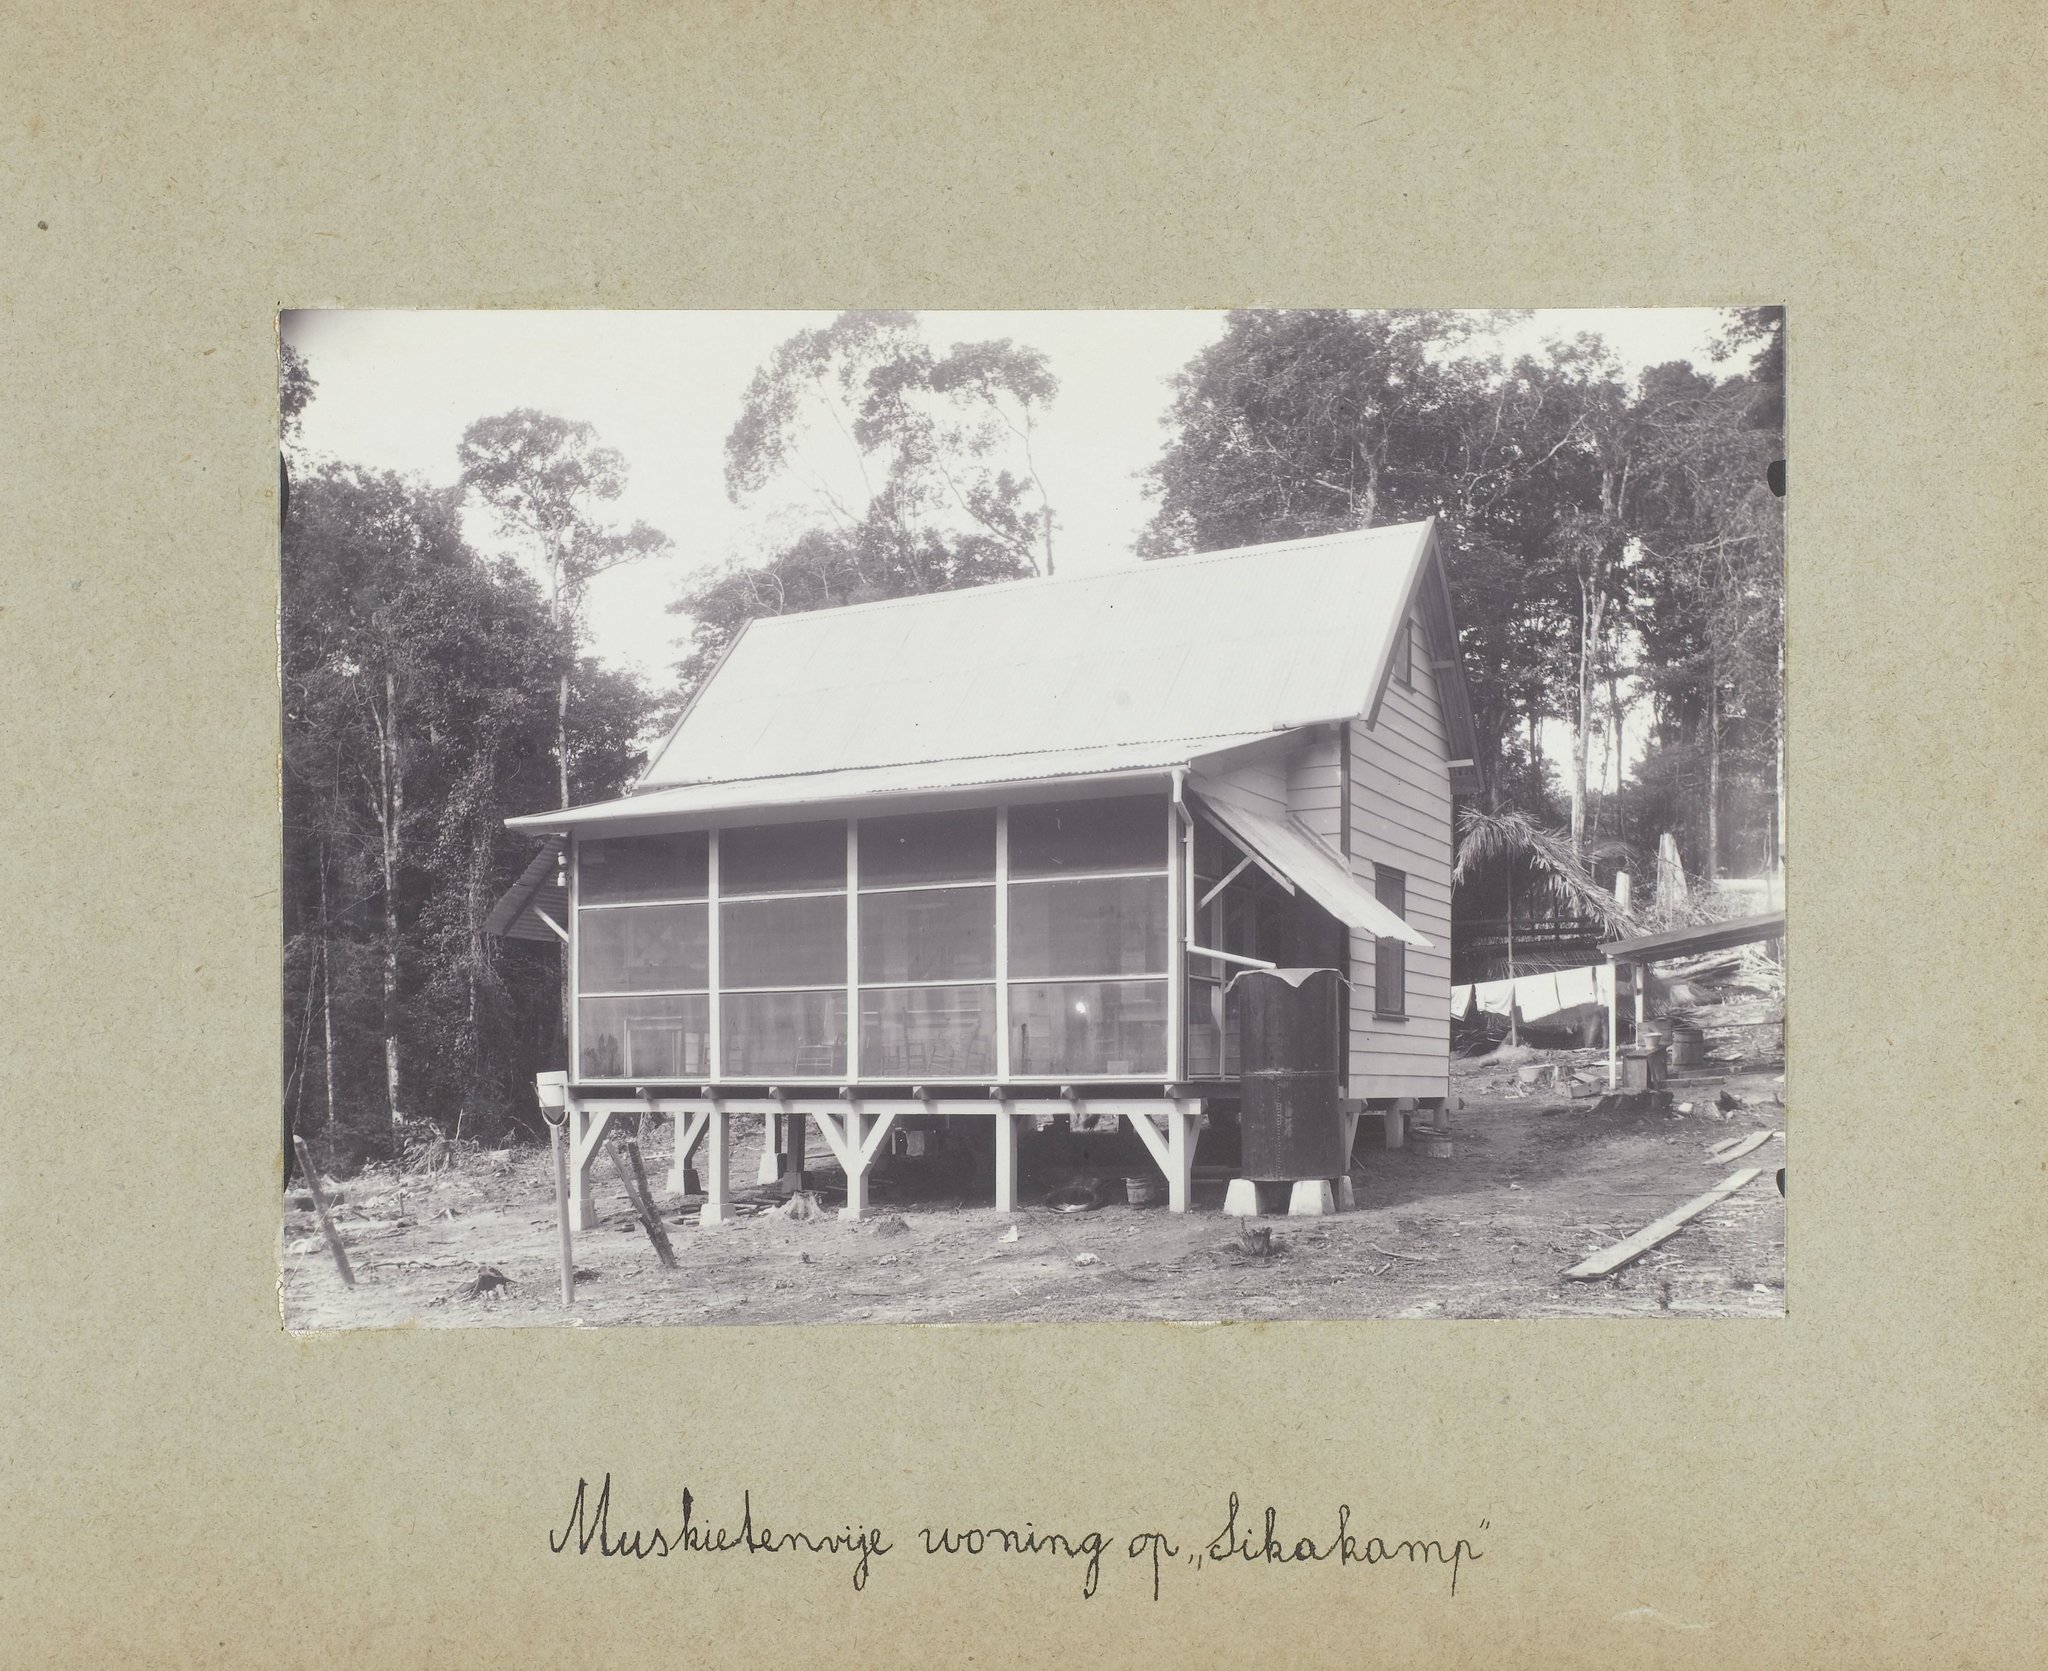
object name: photograph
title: Muskietenvrije woning op "Sikakamp"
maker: Anonymous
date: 1905-1910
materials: photographic support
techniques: photography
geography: suriname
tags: jacob evert wesenhagen, railway, tramway; rack railway, suriname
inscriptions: inscription: ‘Muskietenvrije woning op "Sikakamp"’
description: Woning op Sikakamp, de veranda en ramen voorzien van horren tegen muskieten. Foto in het fotoalbum over de aanleg van de Lawaspoorweg in Suriname in de jaren 1903-1912. Onderdeel van een groep objecten afkomstig van de familie Wesenhagen in Suriname.